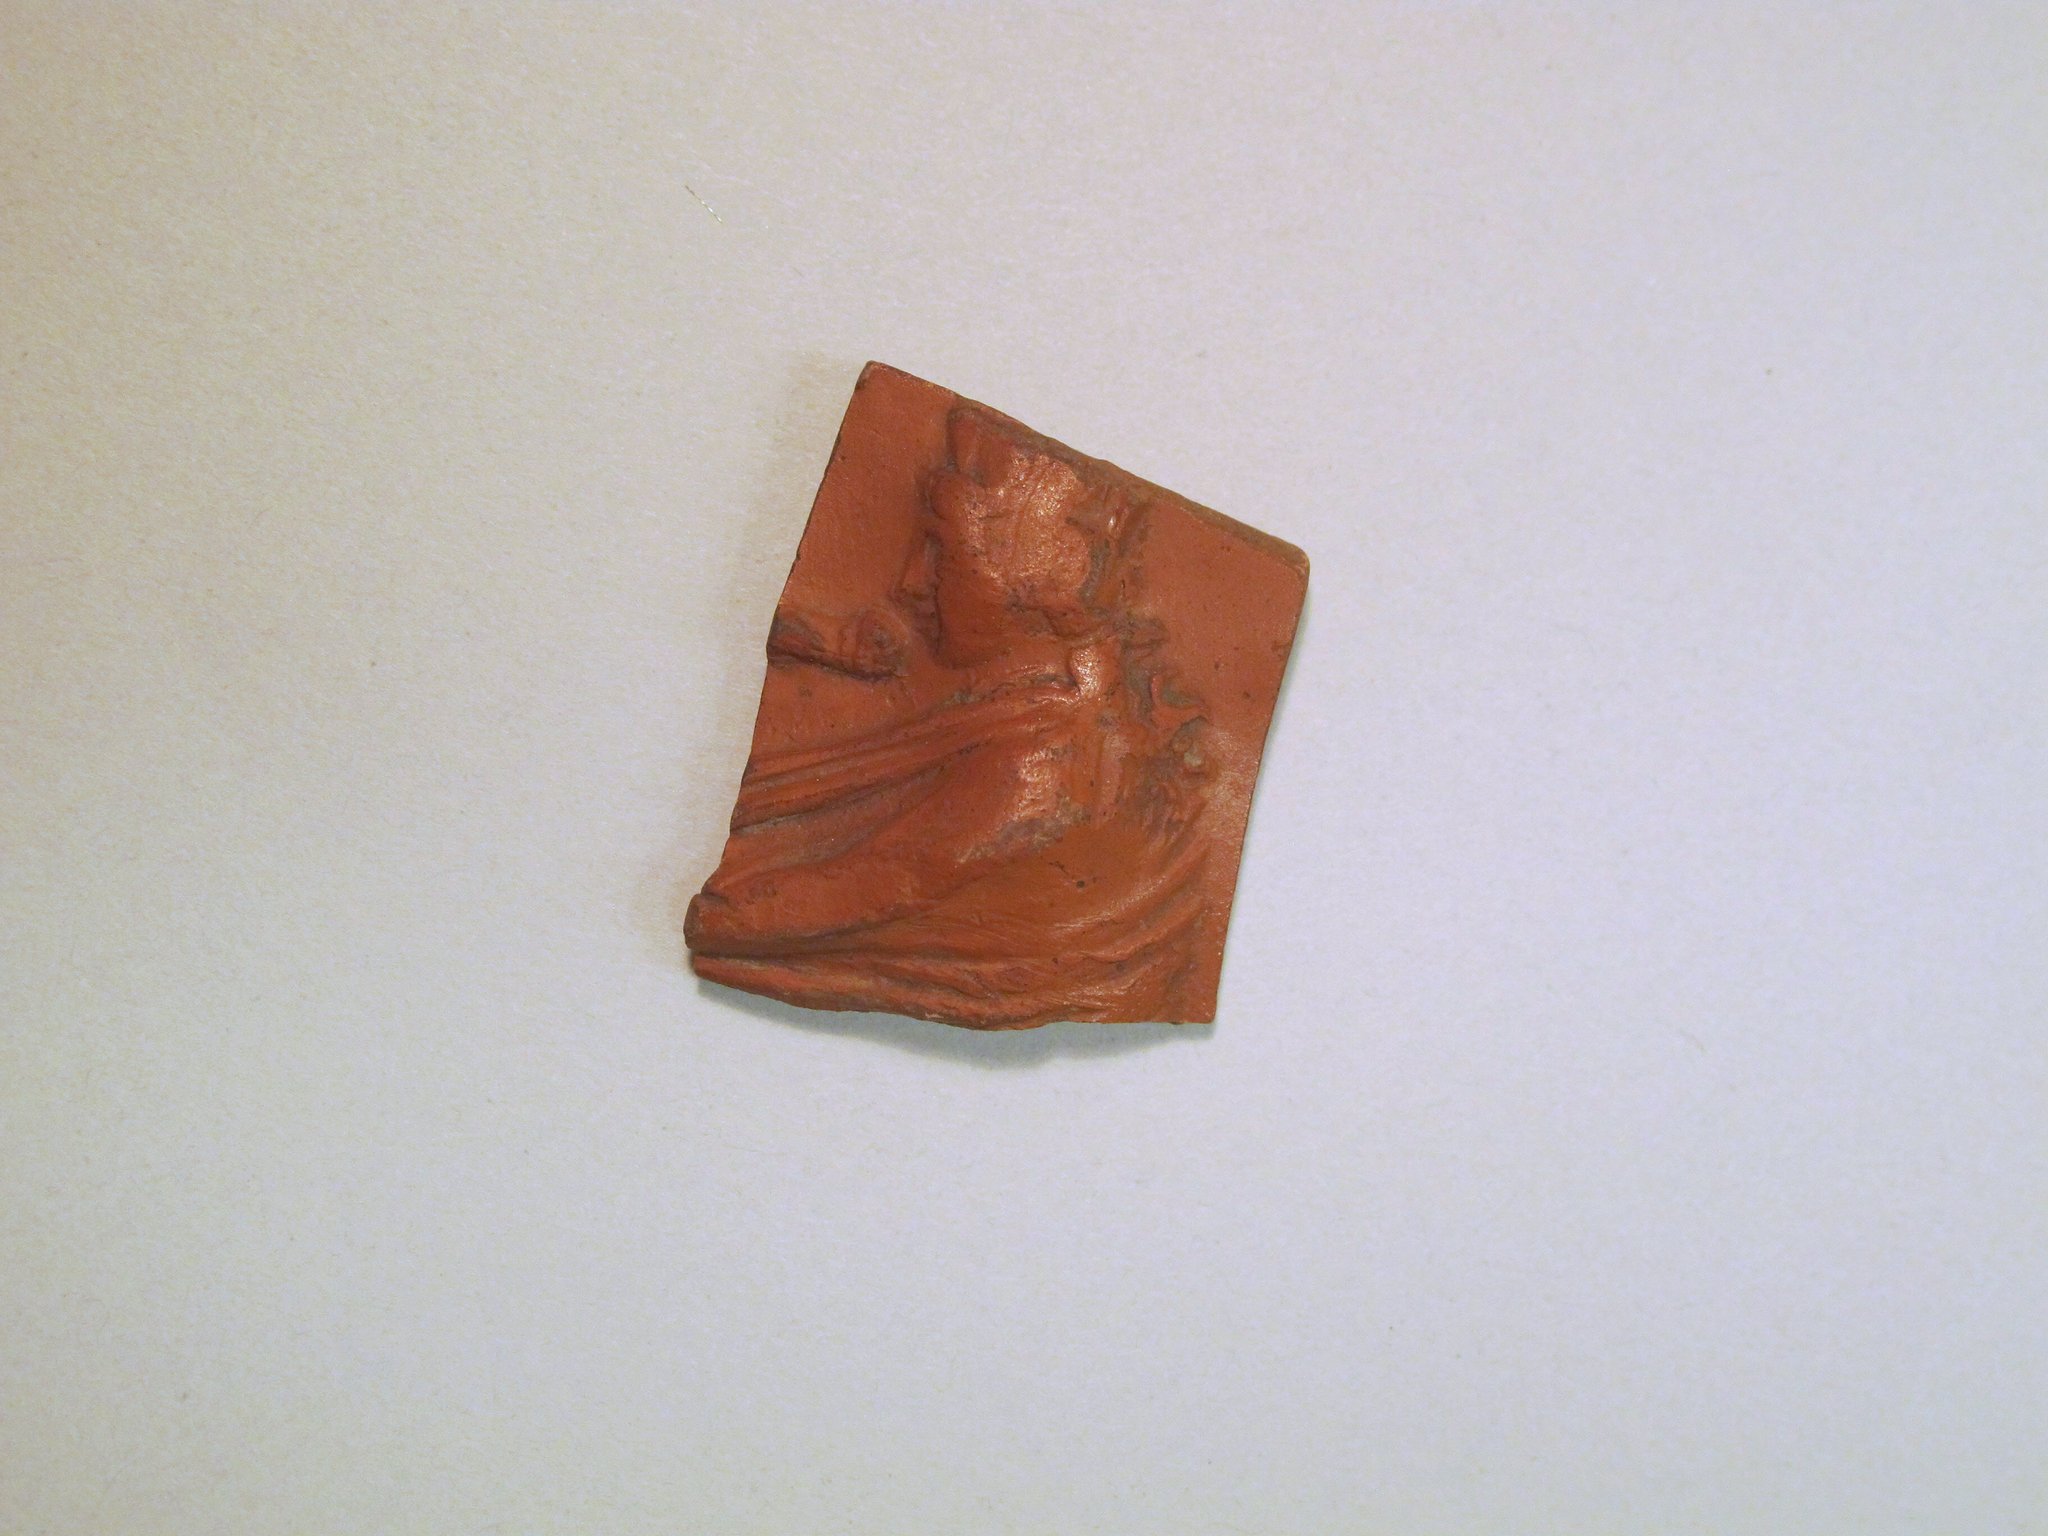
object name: vase fragment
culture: roman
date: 100 BCE-100 CE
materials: terracotta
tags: women